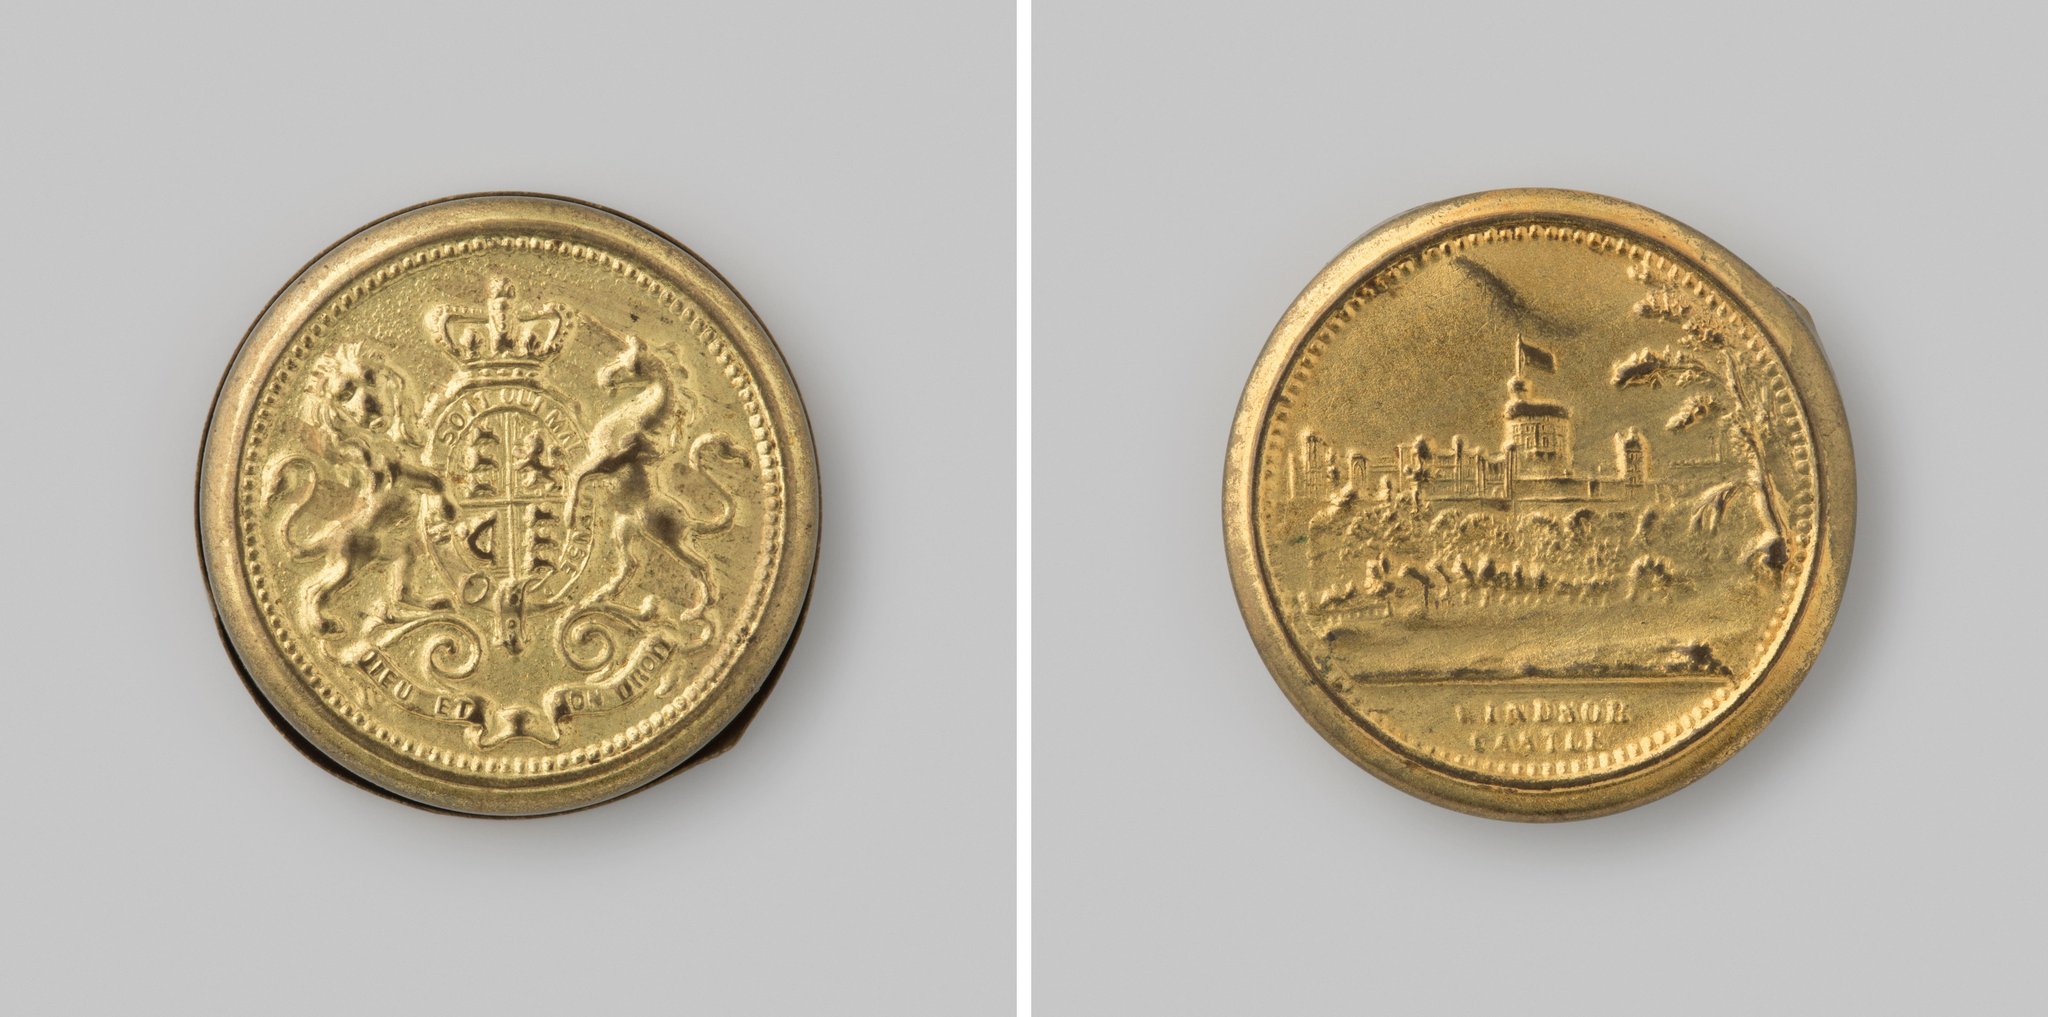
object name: history medal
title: "Windsor Castle" doosje met miniatuurpenningen met het portret van leden van de Engelse koninklijke familie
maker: joseph moore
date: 1850-1890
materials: brass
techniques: pressing, striking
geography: birmingham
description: Klein messing doosje met deksel, met reliëfafbeelding van het Britse wapen met dragers resp. Windsor Castle, inhoudend een miniatuurpenning op naam van Koningin Victoria (10 mm).